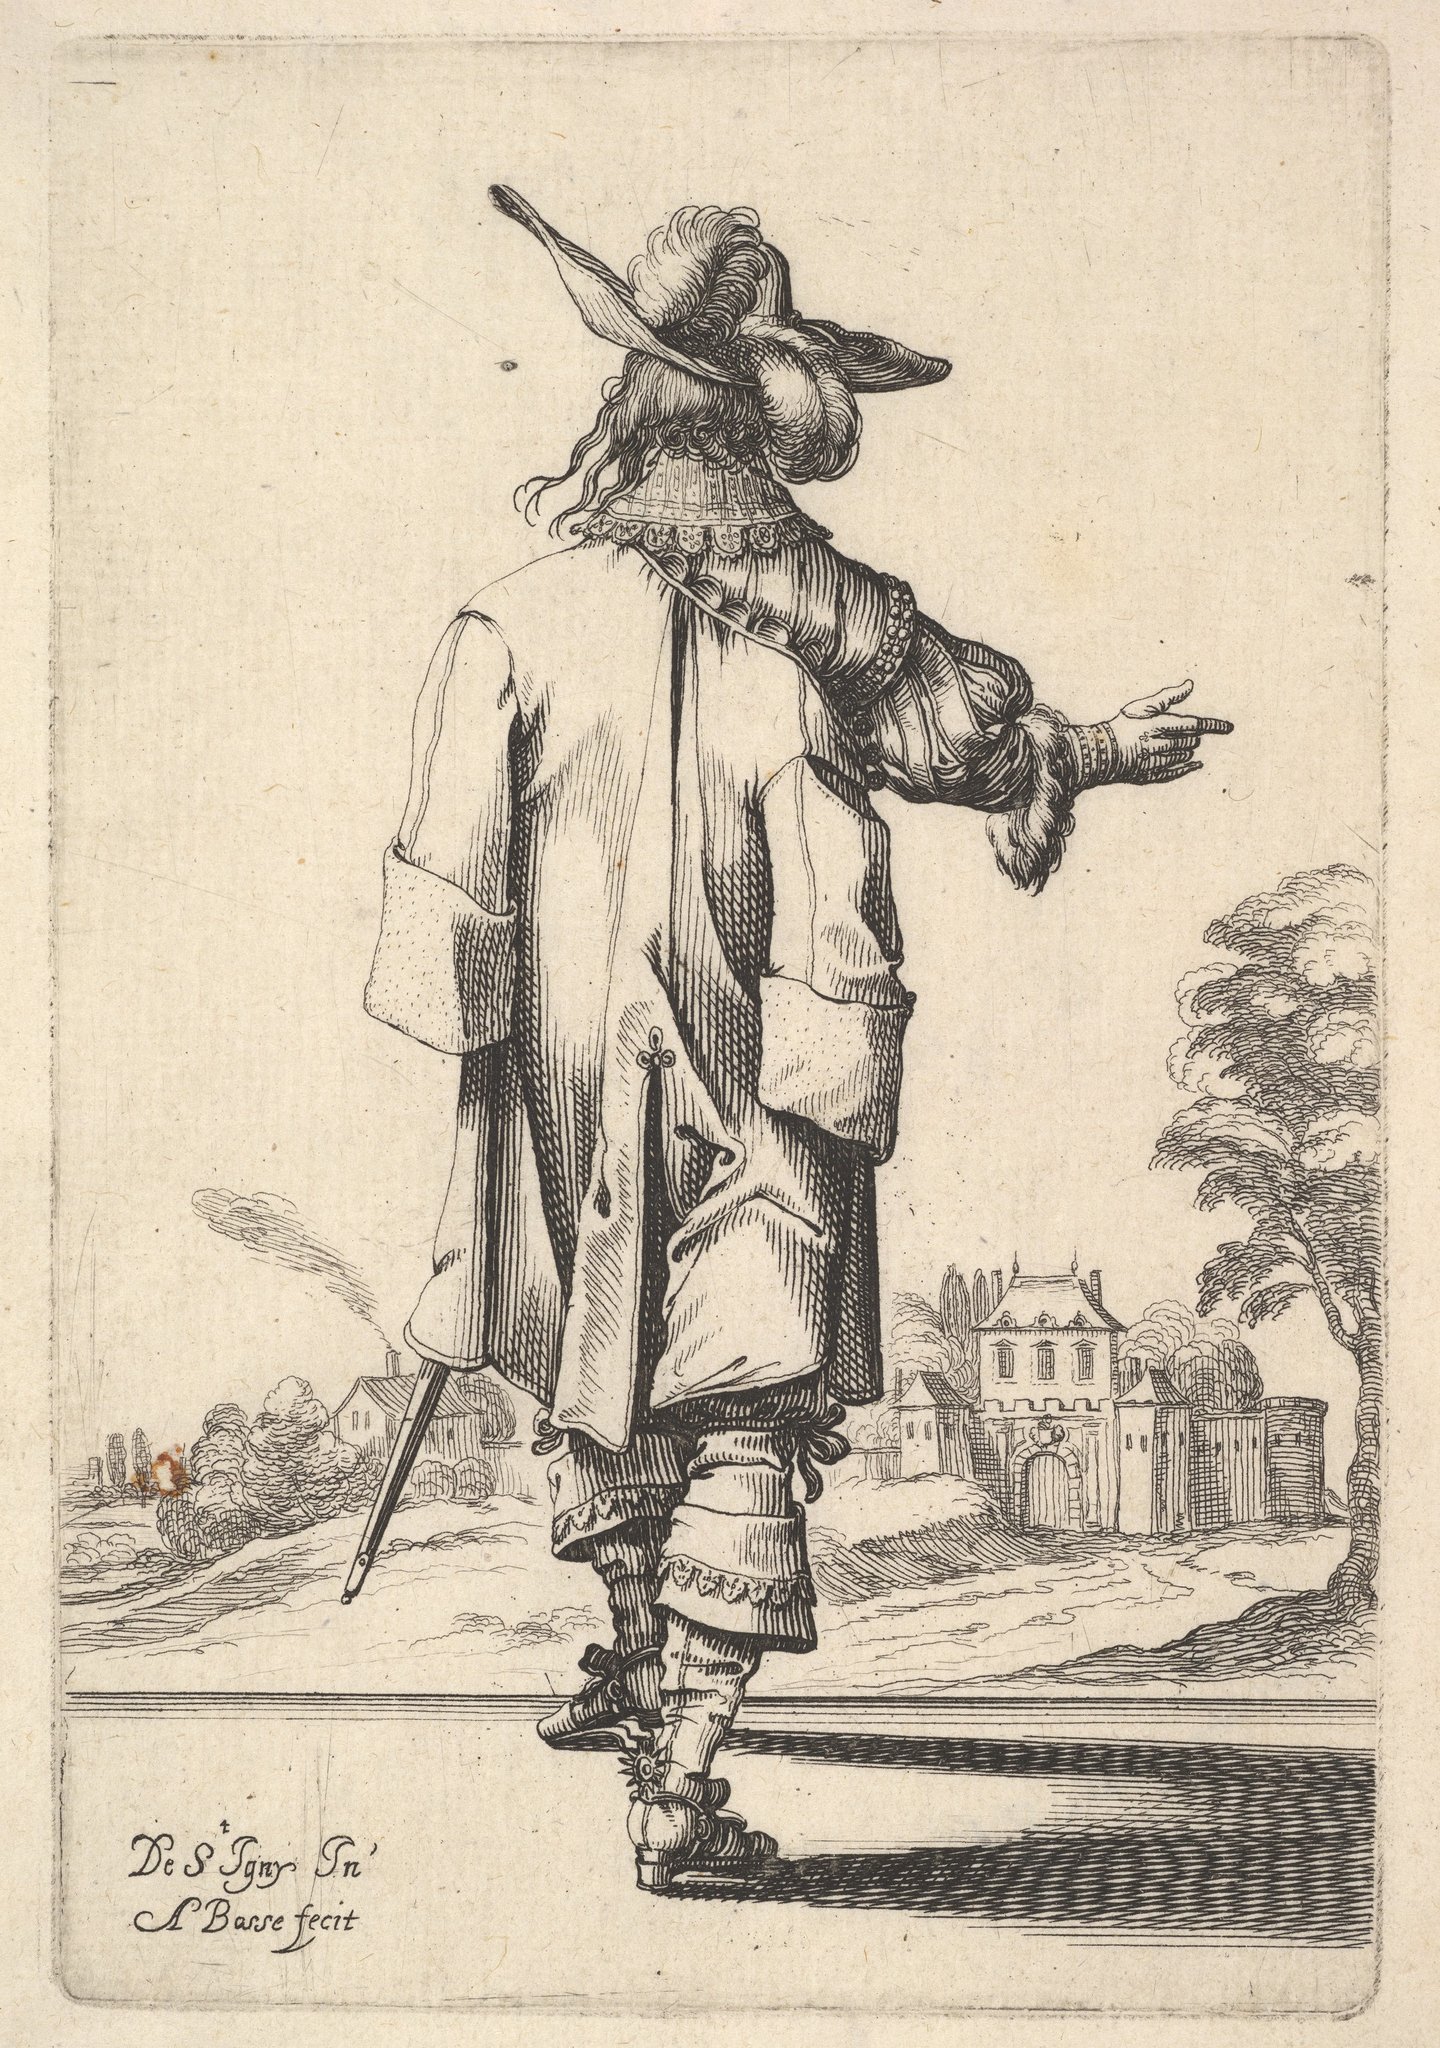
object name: print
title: A gentleman, seen from behind, with his right arm outstretched and a cloak over his left shoulder, from "The Garden of the French Nobles In Which One Can Pick Up Their Way of Dressing"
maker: abraham bosse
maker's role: artist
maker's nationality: french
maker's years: 1602-1676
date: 1629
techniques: etching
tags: men